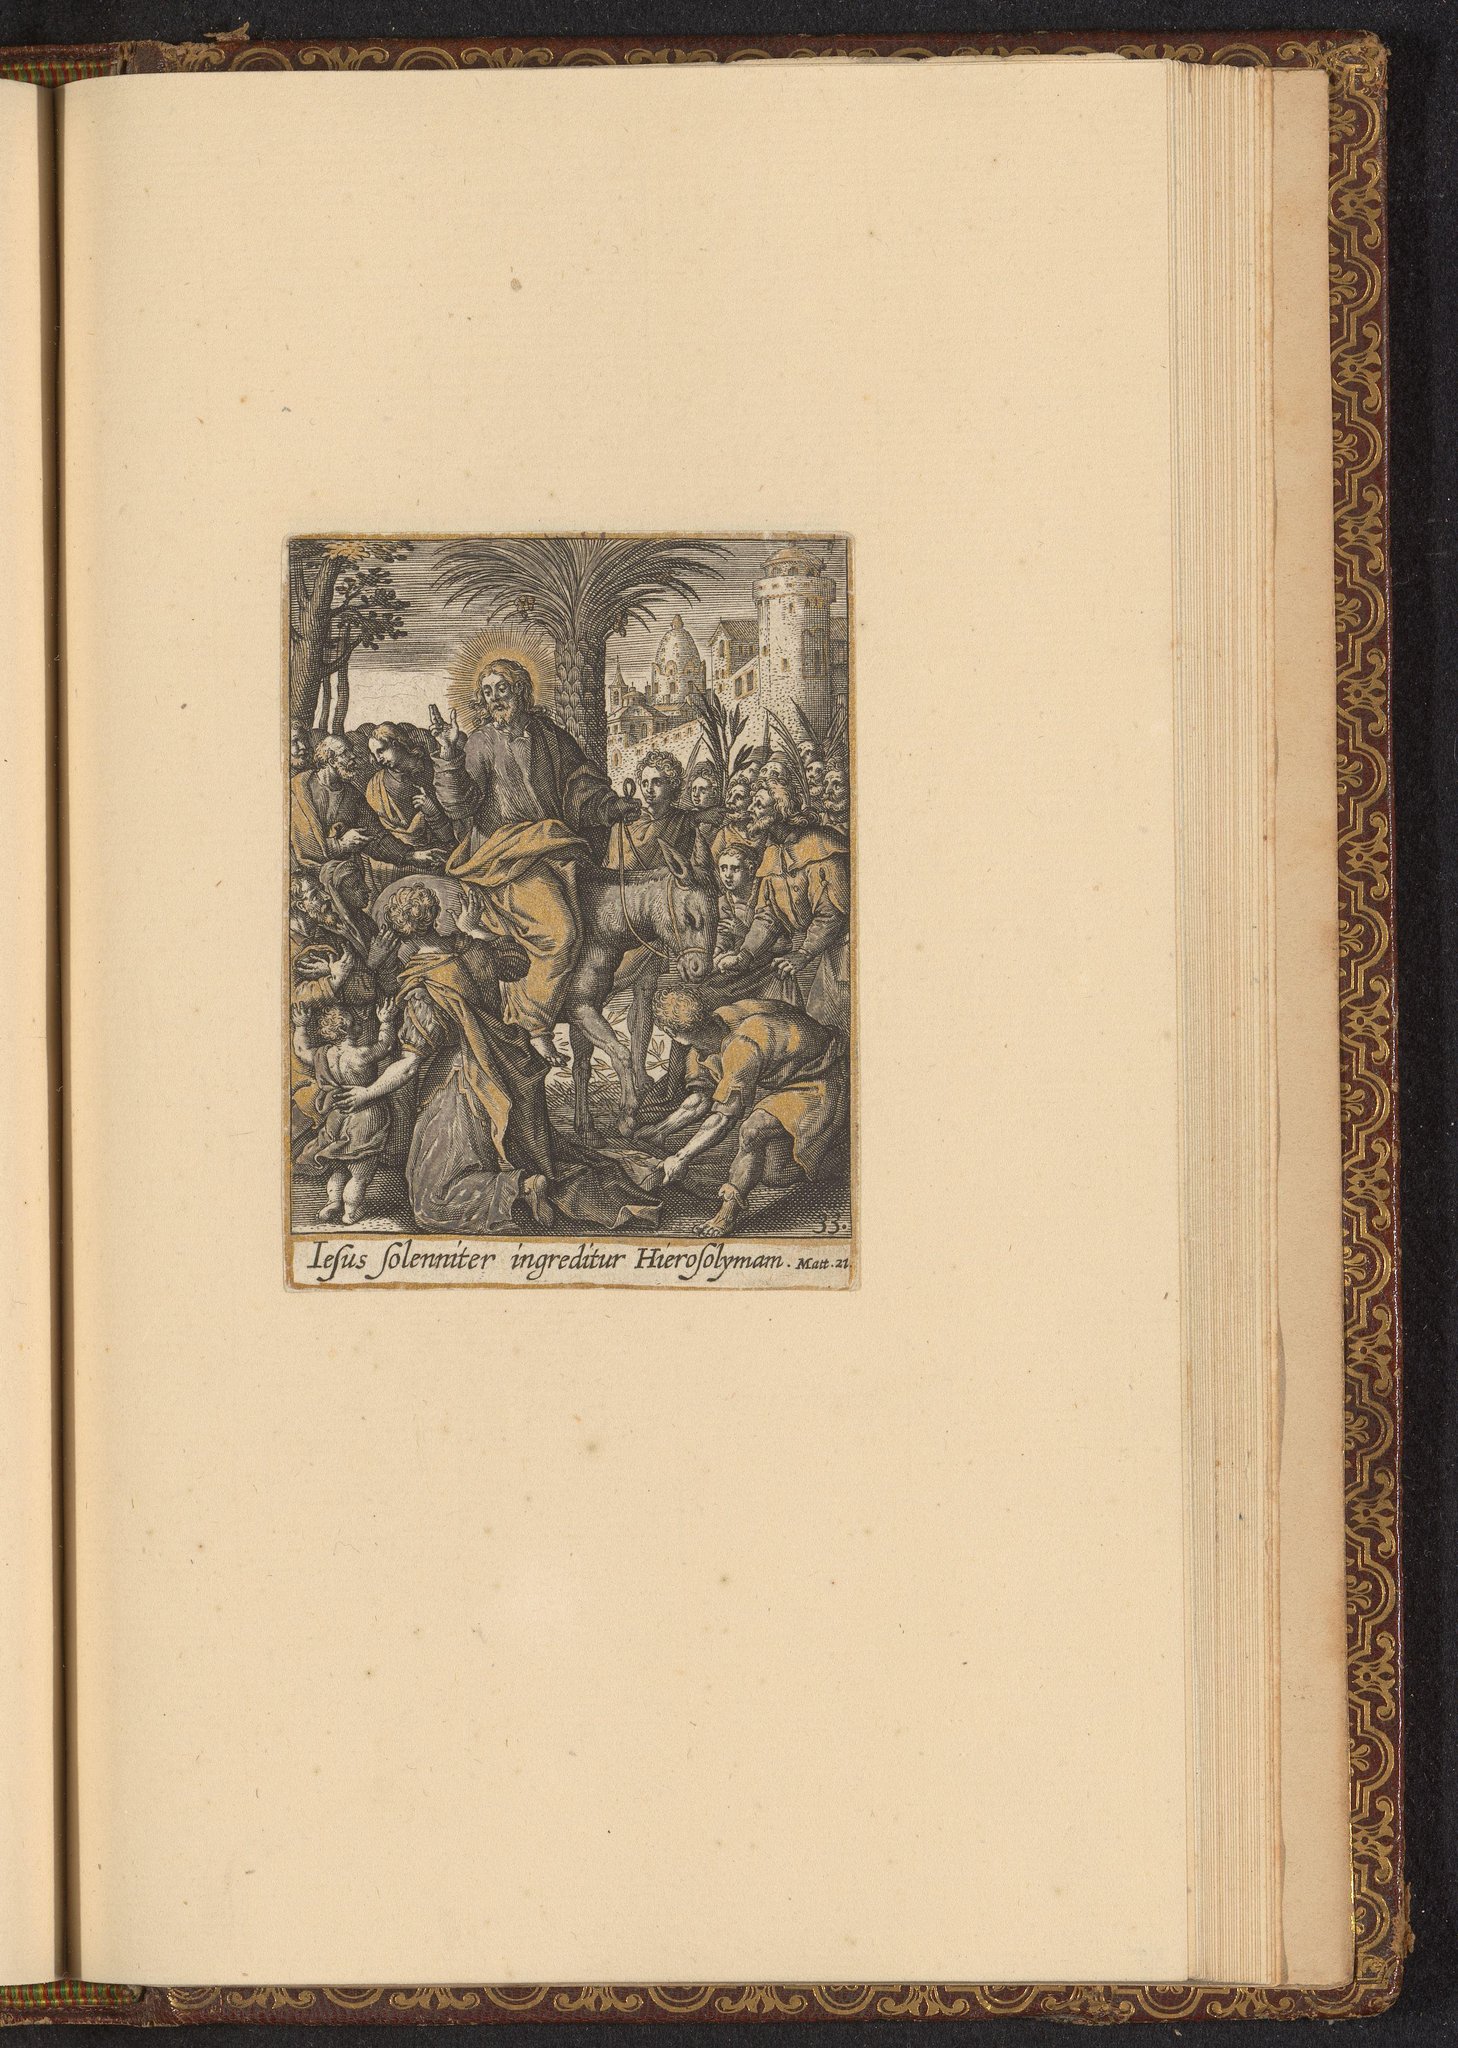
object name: print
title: Vita Iesu Salvatoris varijs iconibus ab Adriano Collaert expressa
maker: adriaen collaert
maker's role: draughtsman, print maker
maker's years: 1560-1618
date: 1580-1590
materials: gold, paper, silver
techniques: engraving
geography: antwerp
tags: entry into jerusalem: people spreading their clothes before christ on the ass, and waving palm branches (matthew 21:1-11, 21:14-16; mark 11:1-11; luke 19:28-40; john 12:12-19)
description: De gravures van beide reeksen zijn door dezelfde hand gehoogd met goud en zilver. De eerste reeks van 34 (van 35) gravures is een verkleinde versie naar prenten uit een reeks naar Maarten de Vos (nrs. 2-28, 31-33) met toevoeging van drie scènes uit de Wonderen van Christus (nrs. 26, 28, 30).